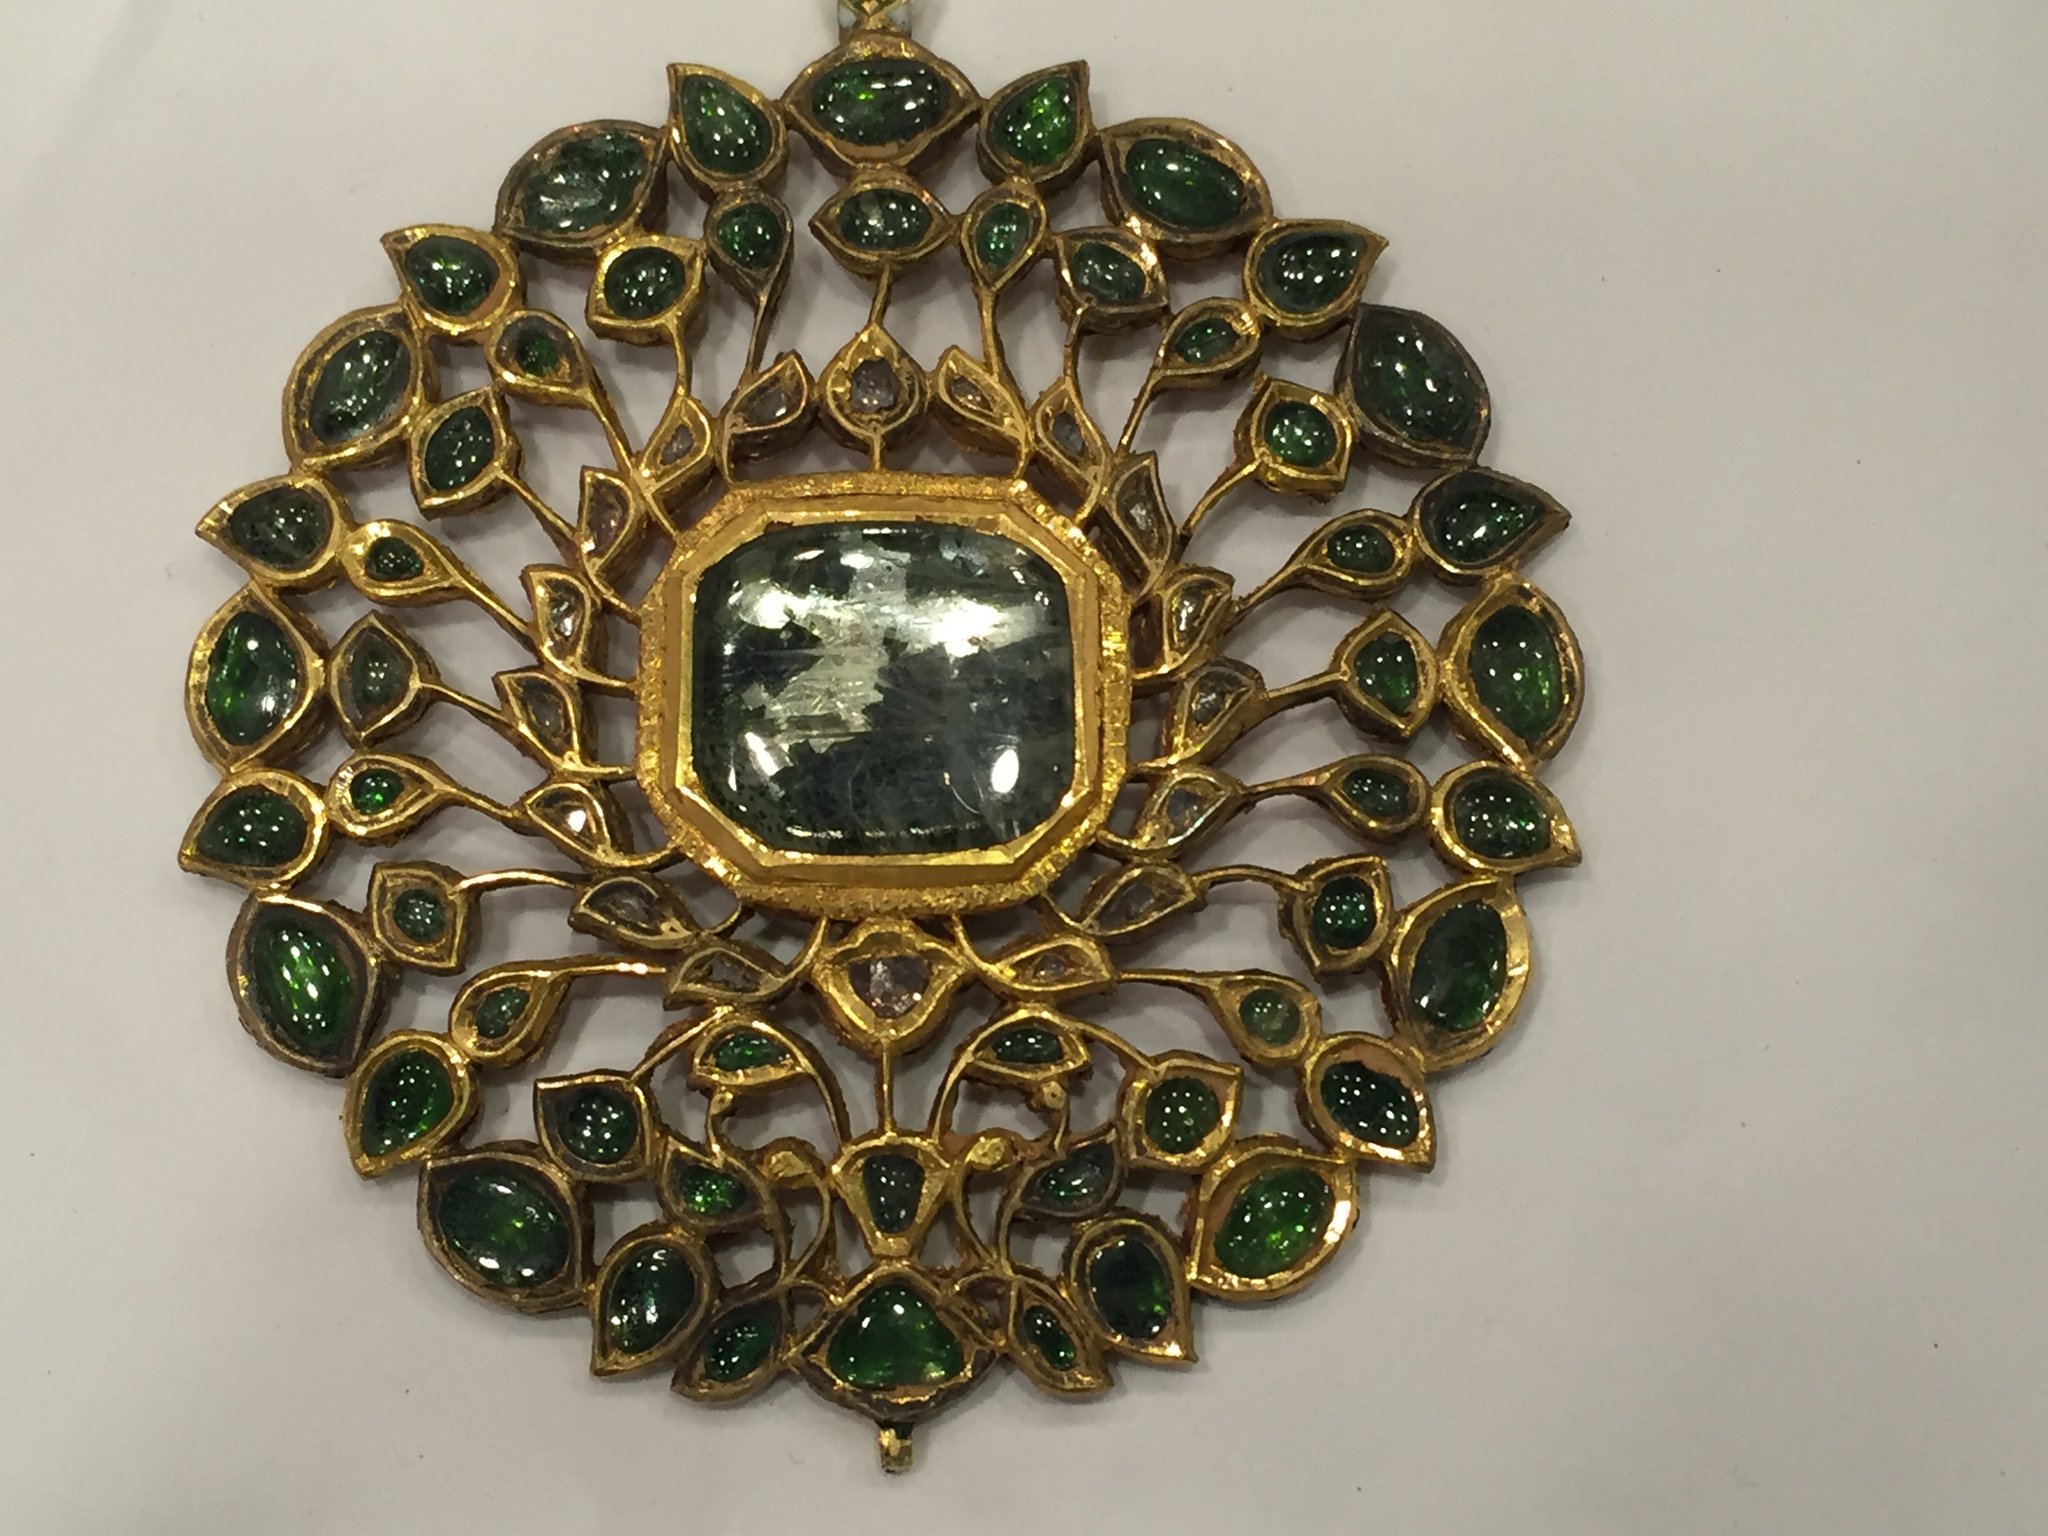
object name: ornament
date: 1801-1900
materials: gold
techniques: enamel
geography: north india